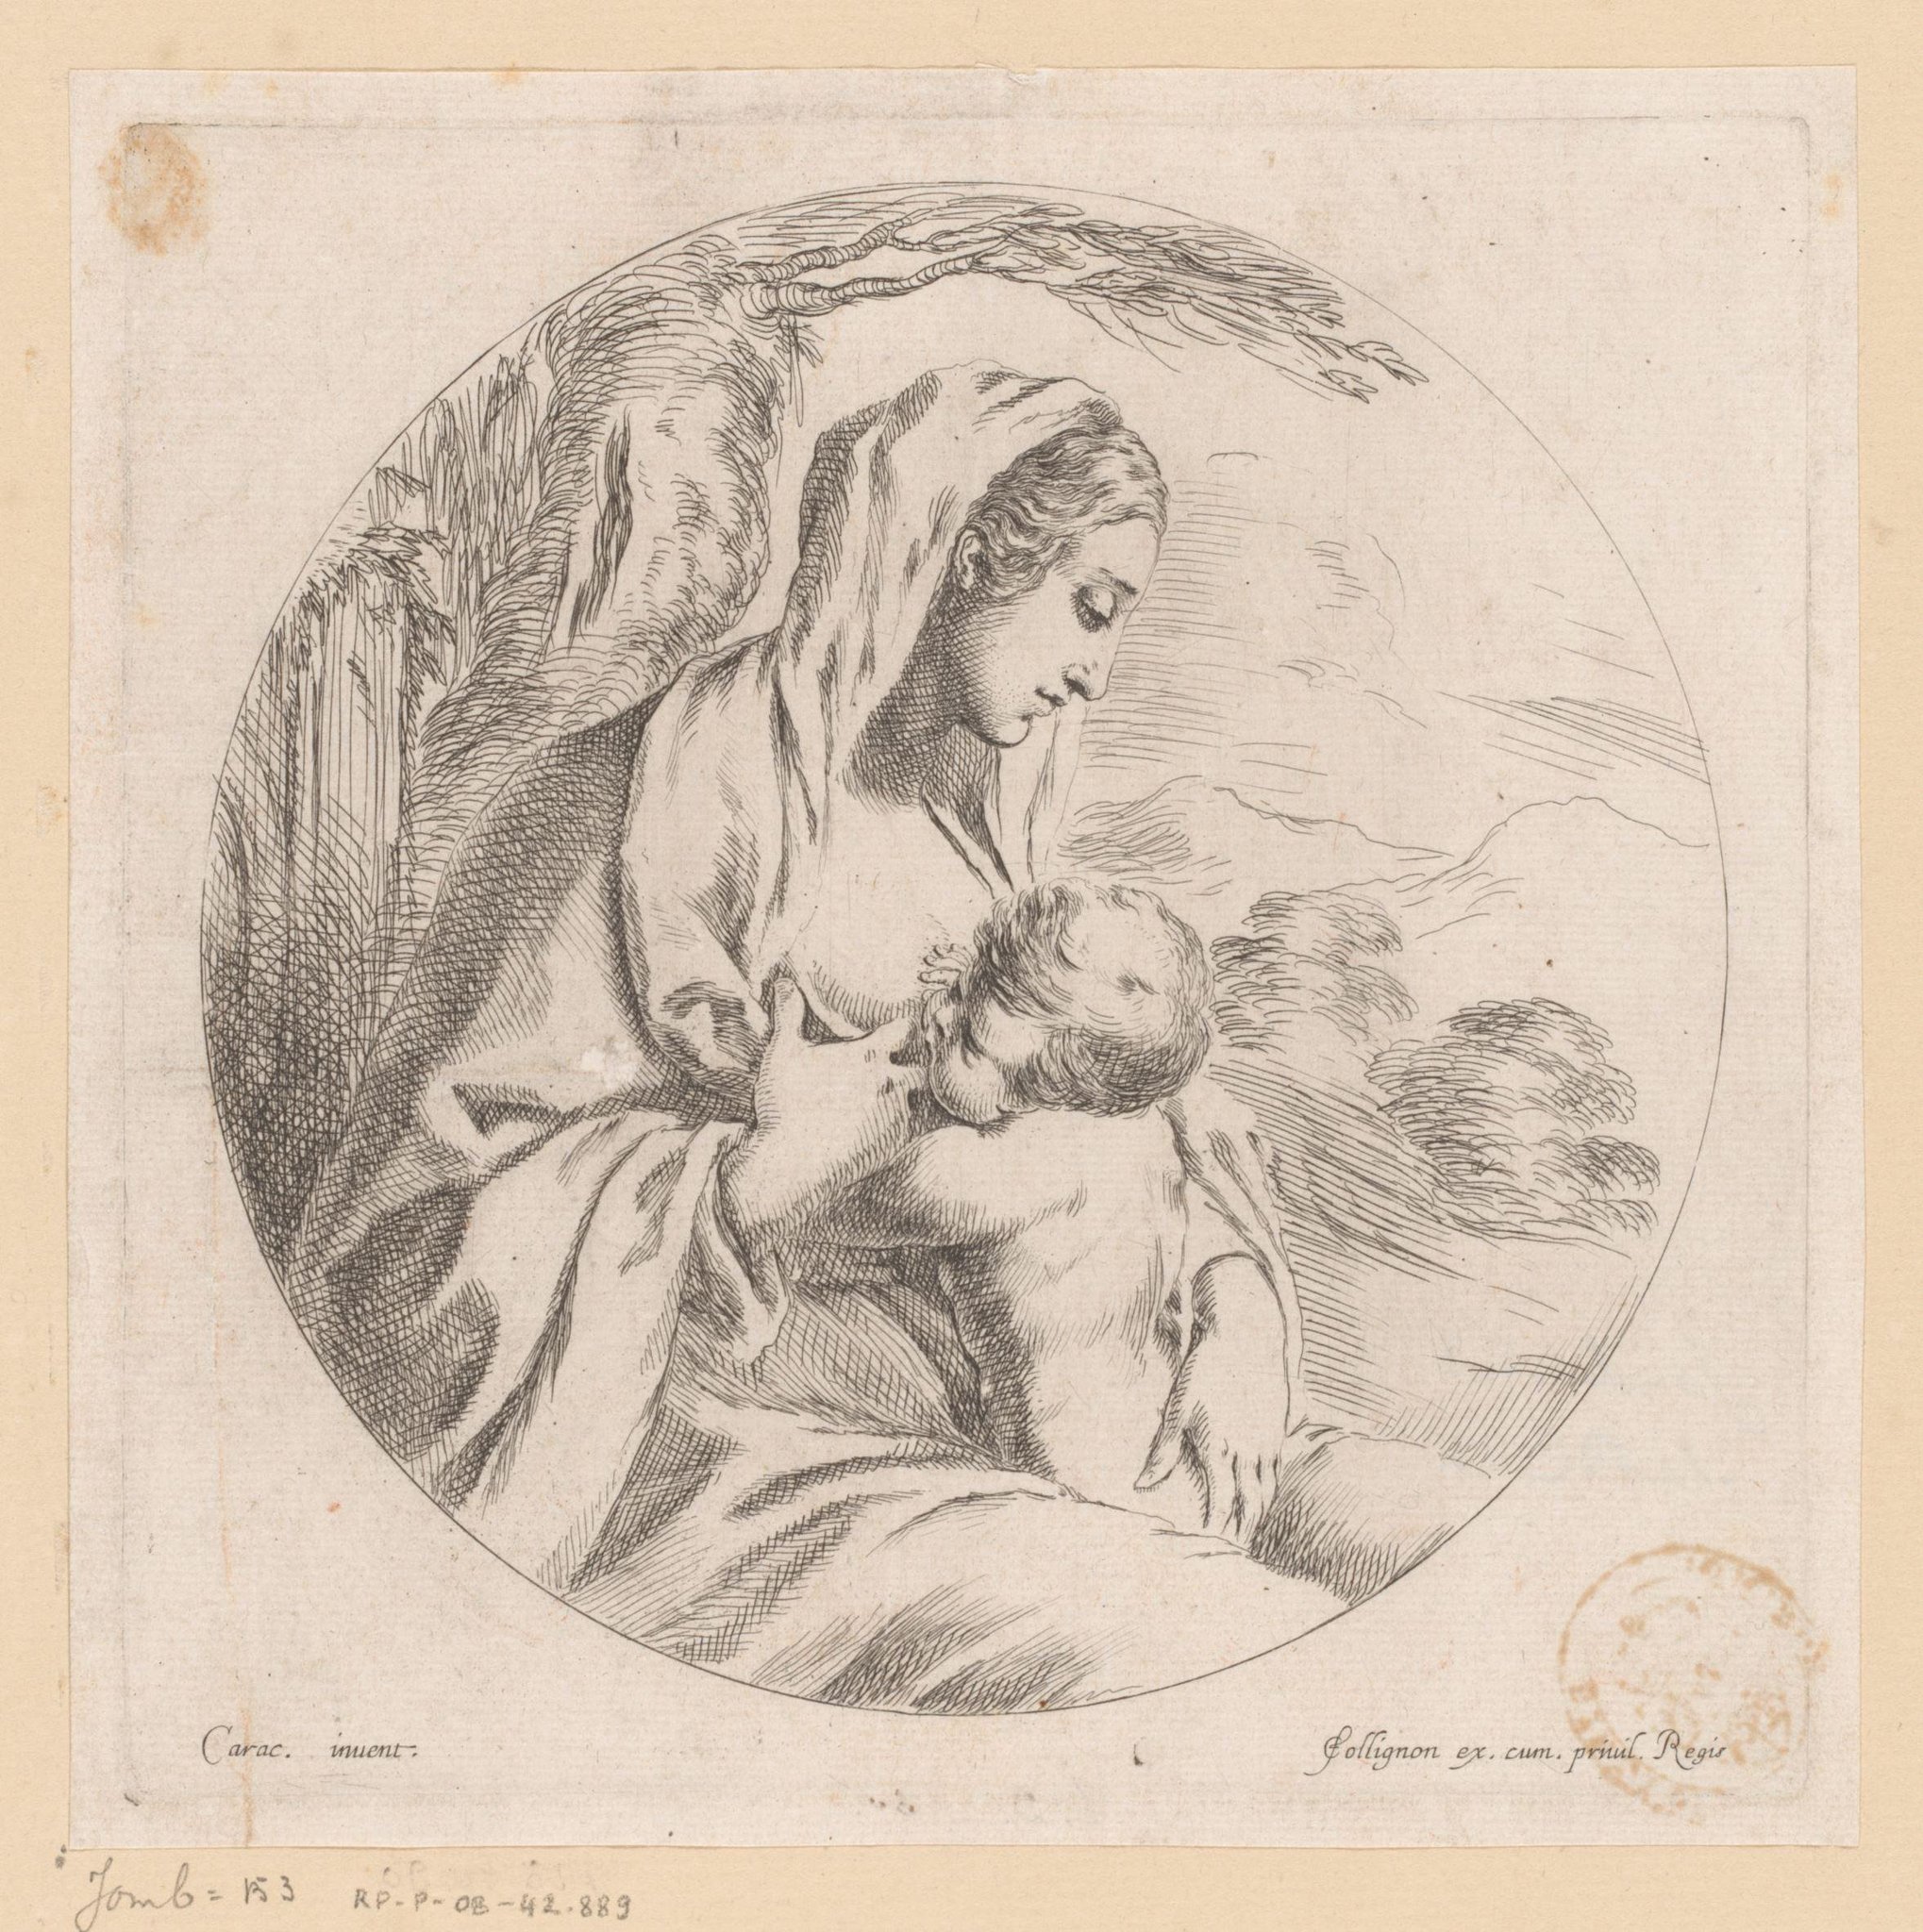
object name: print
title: Maria zoogt het Christuskind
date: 1620-1687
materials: paper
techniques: engraving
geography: france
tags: christ-child suckling, or beginning to suckle, e.g. mary uncovering her breast ~ madonna-representations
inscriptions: collector's mark: Lugt 240